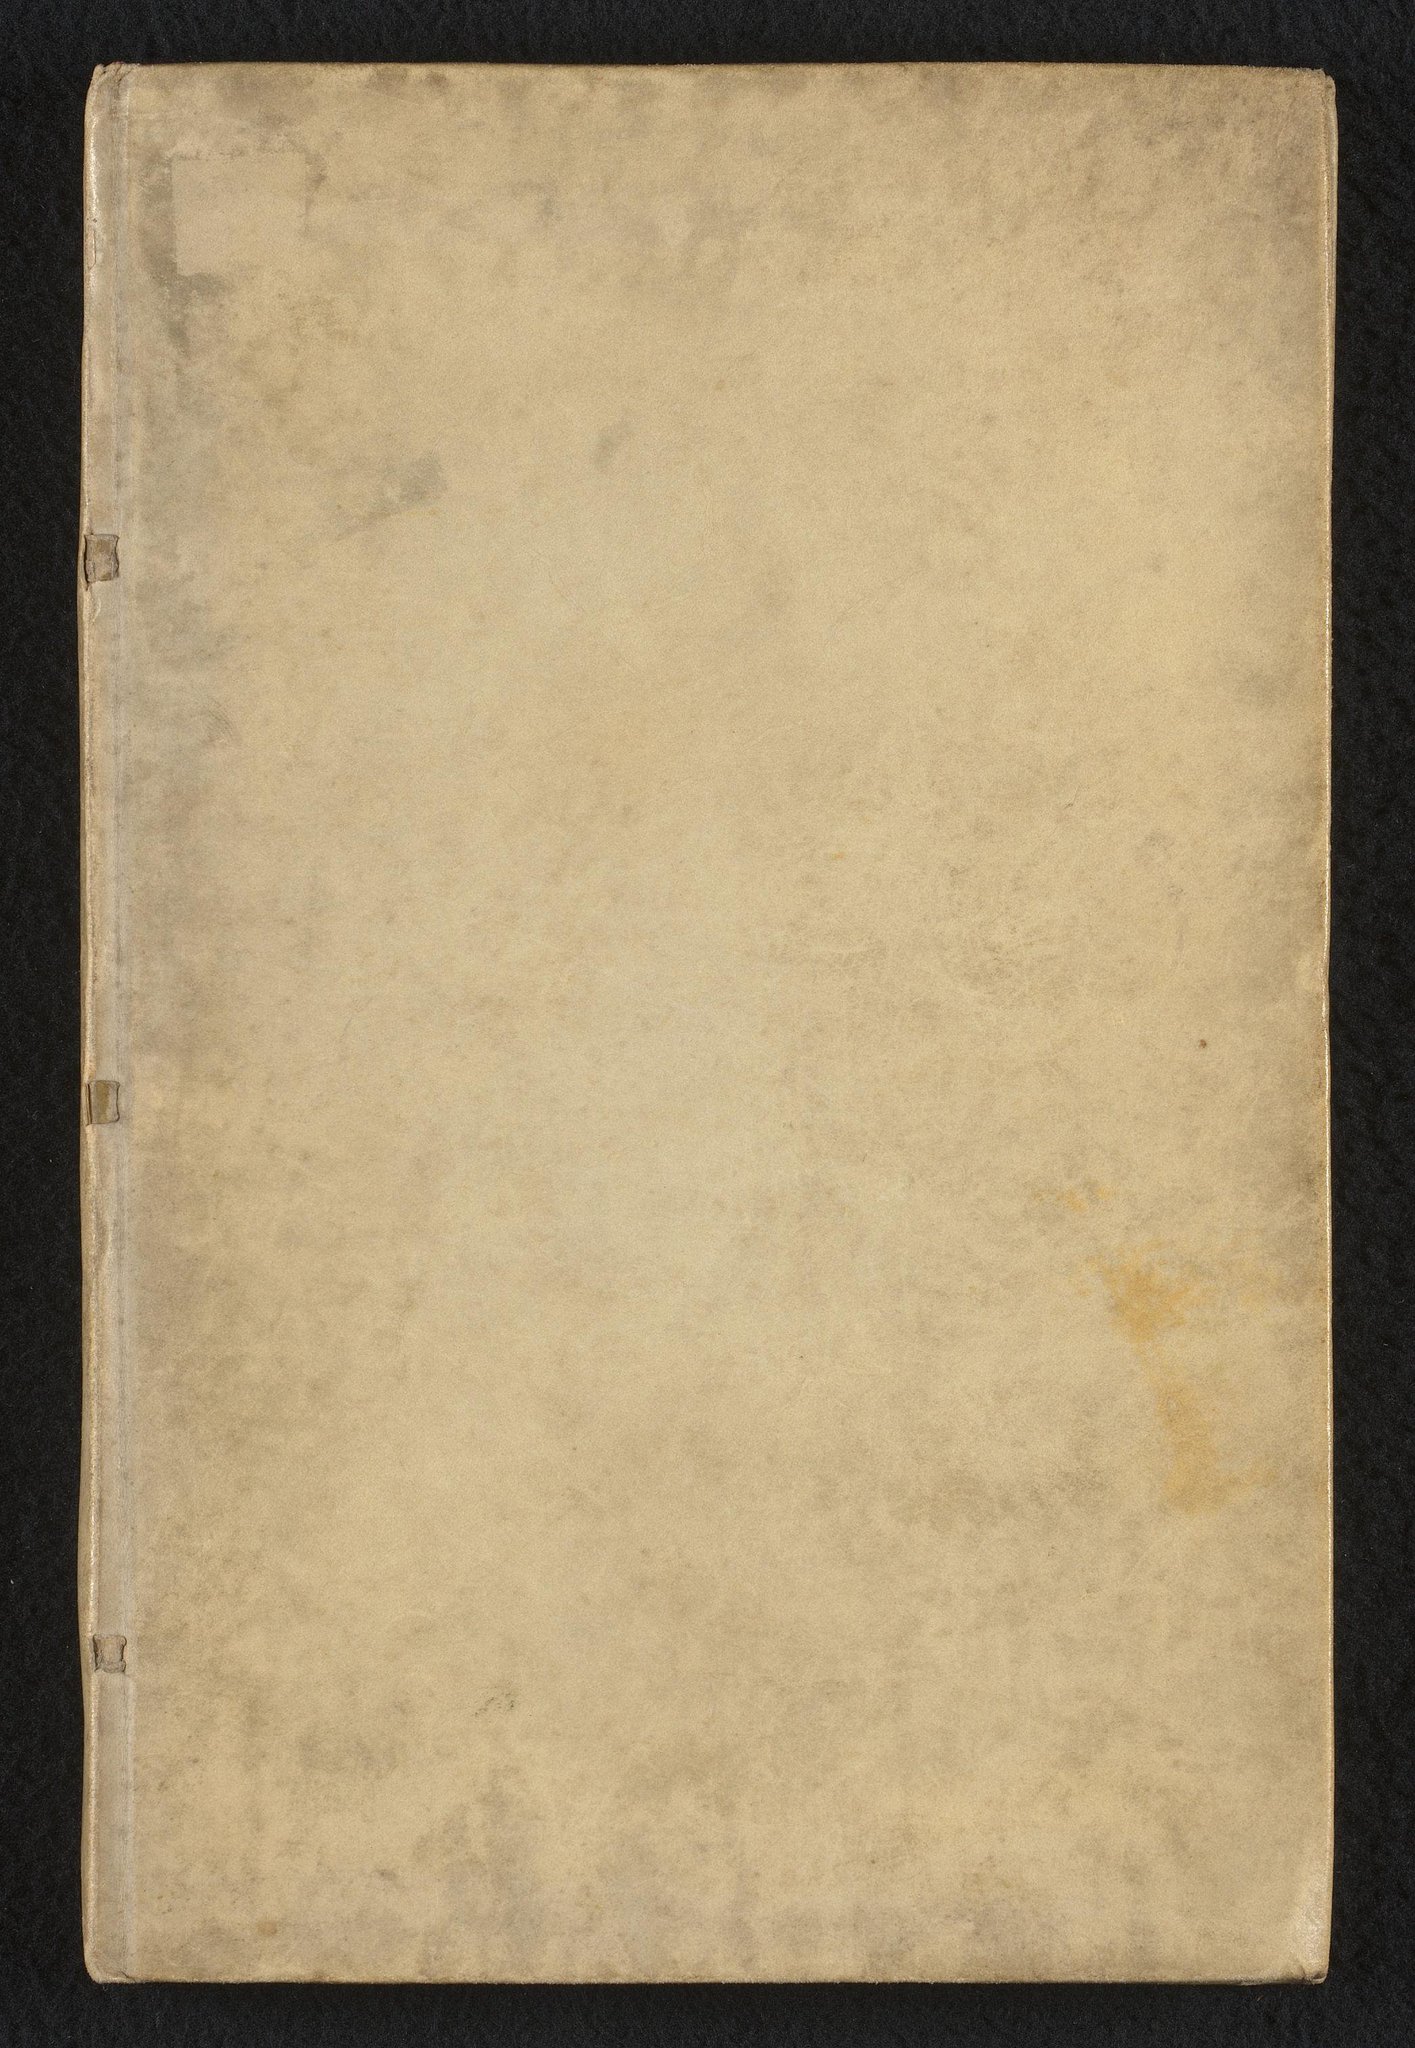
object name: sketchbook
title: Schetsboek met 40 bladen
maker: johann goll van frankenstein (i)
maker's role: amateurtekenaar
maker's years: 1722-1785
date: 1760-1785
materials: paper, parchment, pencil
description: Inhoud: studies van een vrouw met slijpsteen, hooiende boeren, zeilschepen, figuurstudies; gezichten op/bij: Maarssen, in de Plantage te Amsterdam, aan het IJ buiten de Haarlemmerpoort in Amsterdam, tolhuis aan de noordzijde van het IJ, Breukelerweert, Breukelen, de steenoven bij Maarssen, de bierbrouwerij bij Breukelen, bij Tienhoven, de hermitage bij Maarssen, Maarsseveen, Marie Hofstede bij Maarssen, de Vecht bij Maarssen, ’t Zwarte Varken, ’t Kraiennest, de korenmolen bij Breukelen.